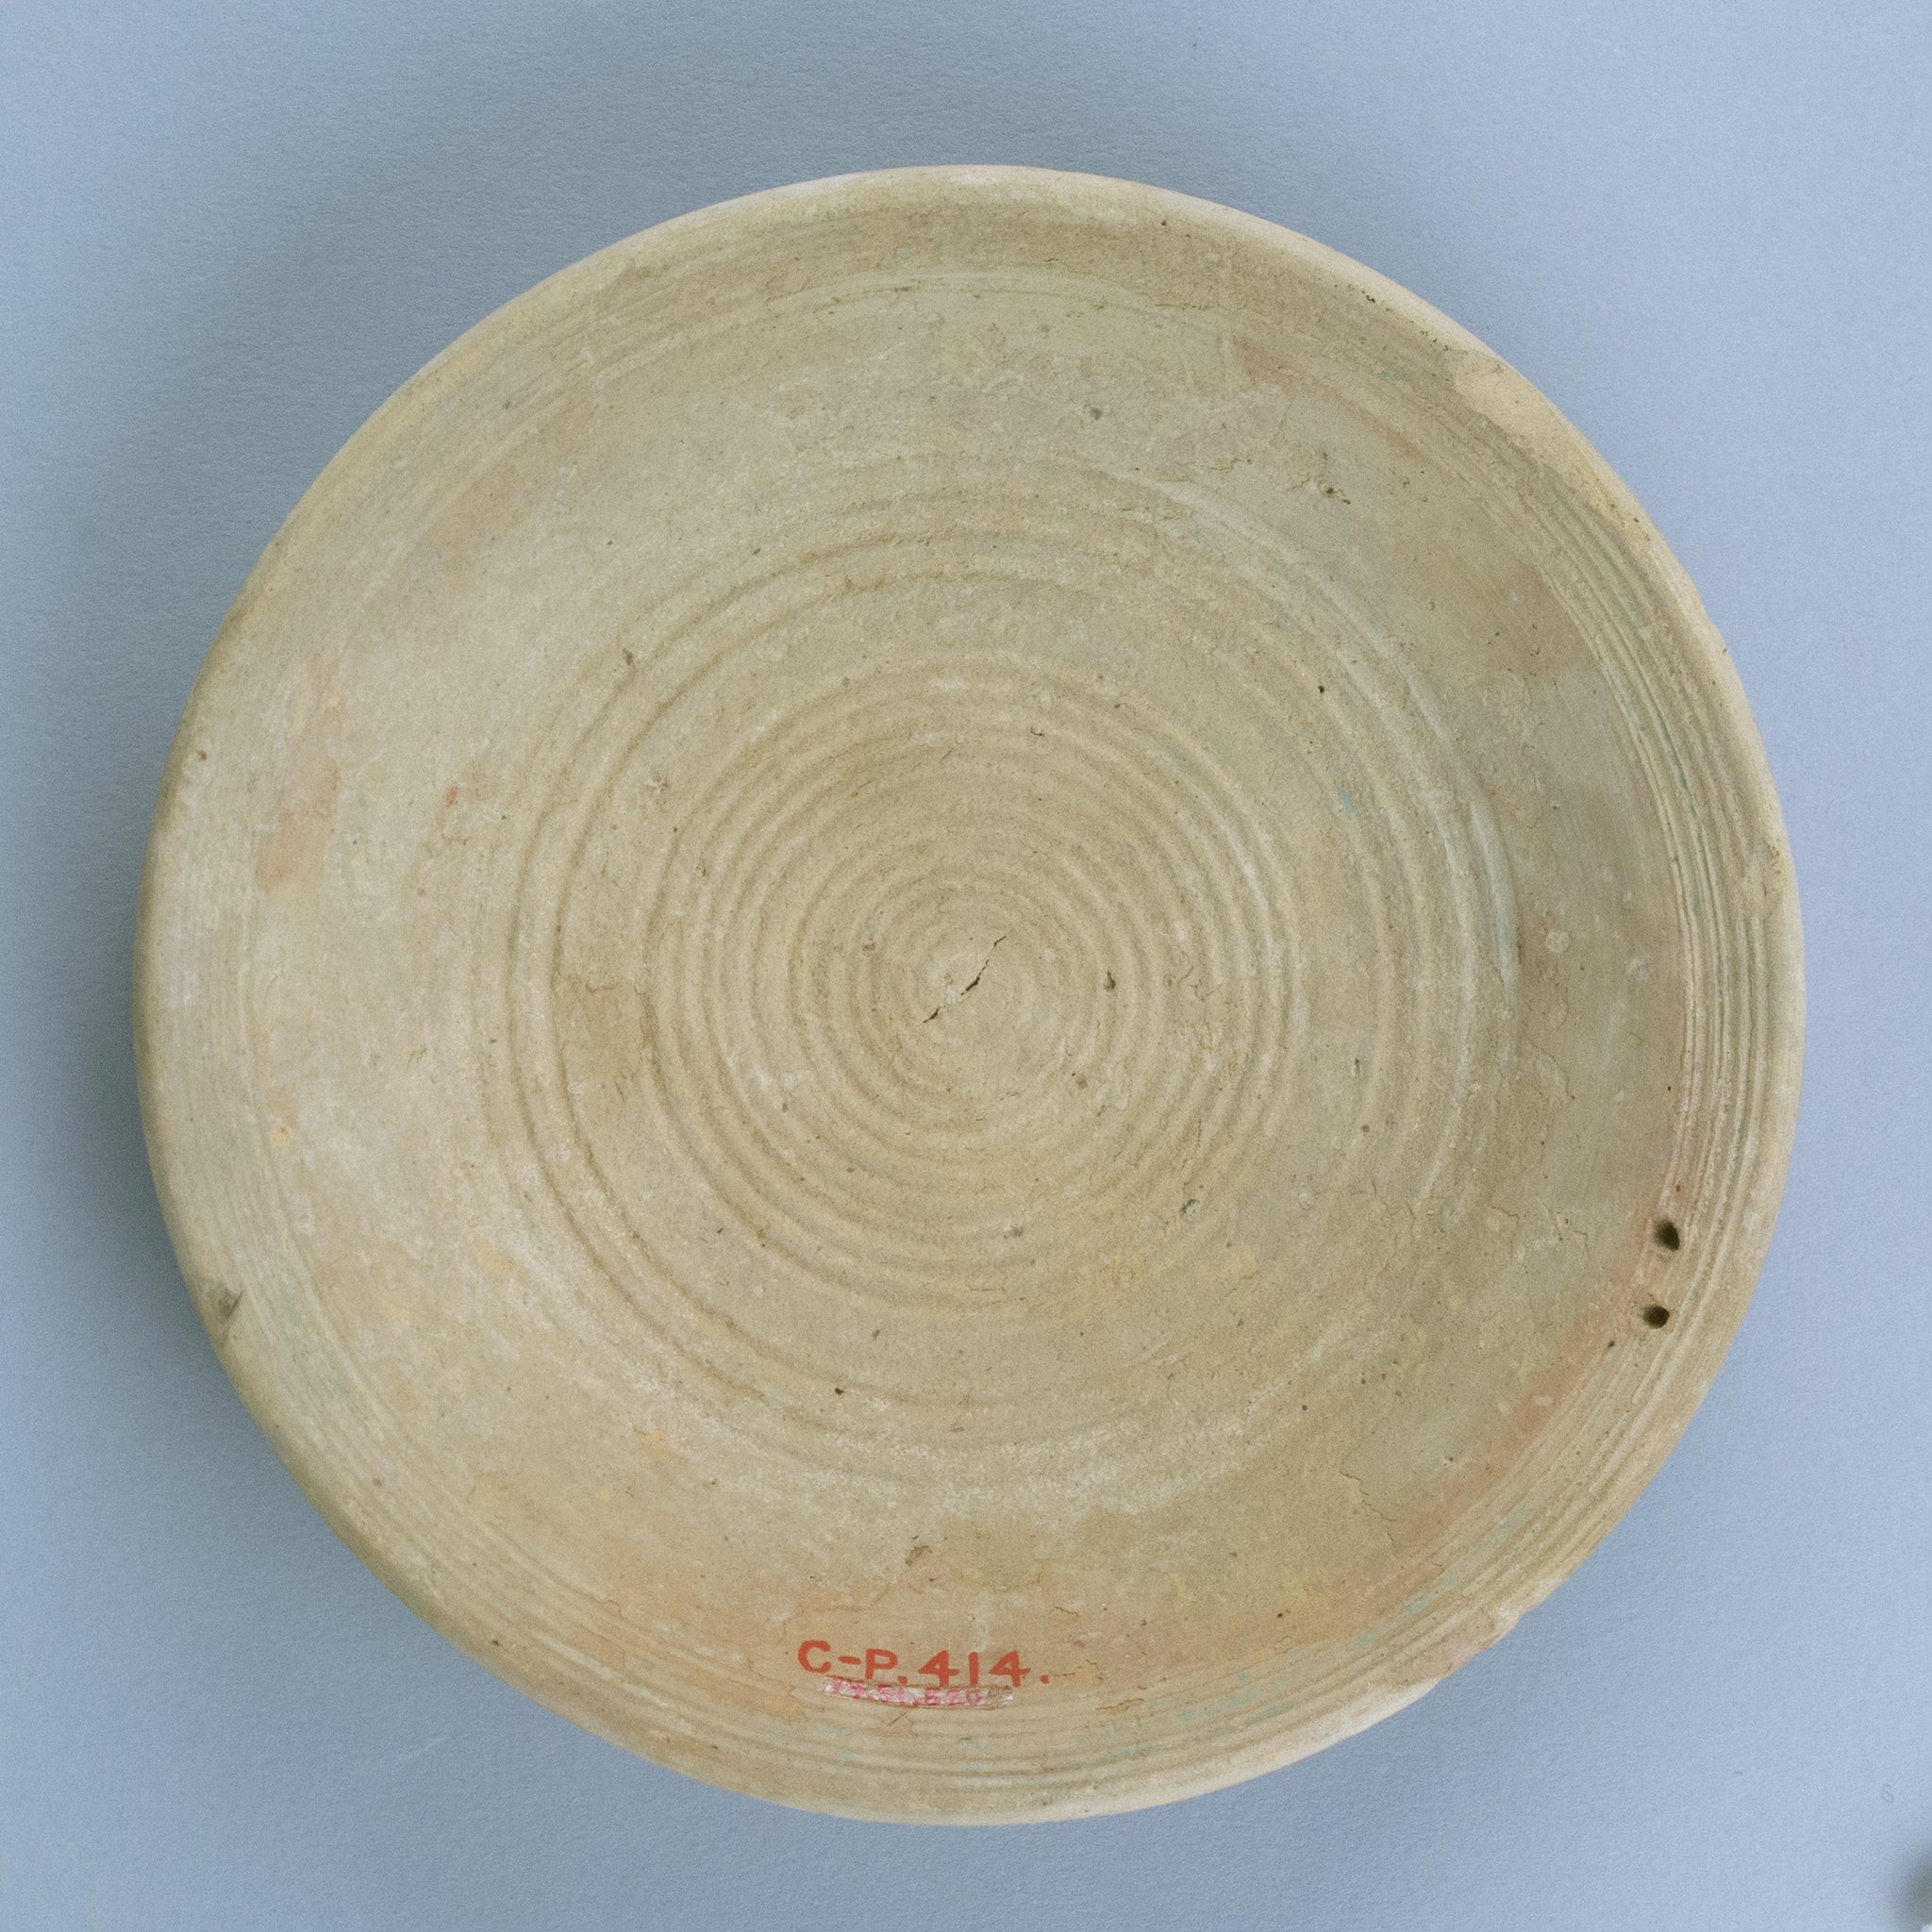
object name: bowl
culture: cypriot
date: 1125-1050 BCE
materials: terracotta